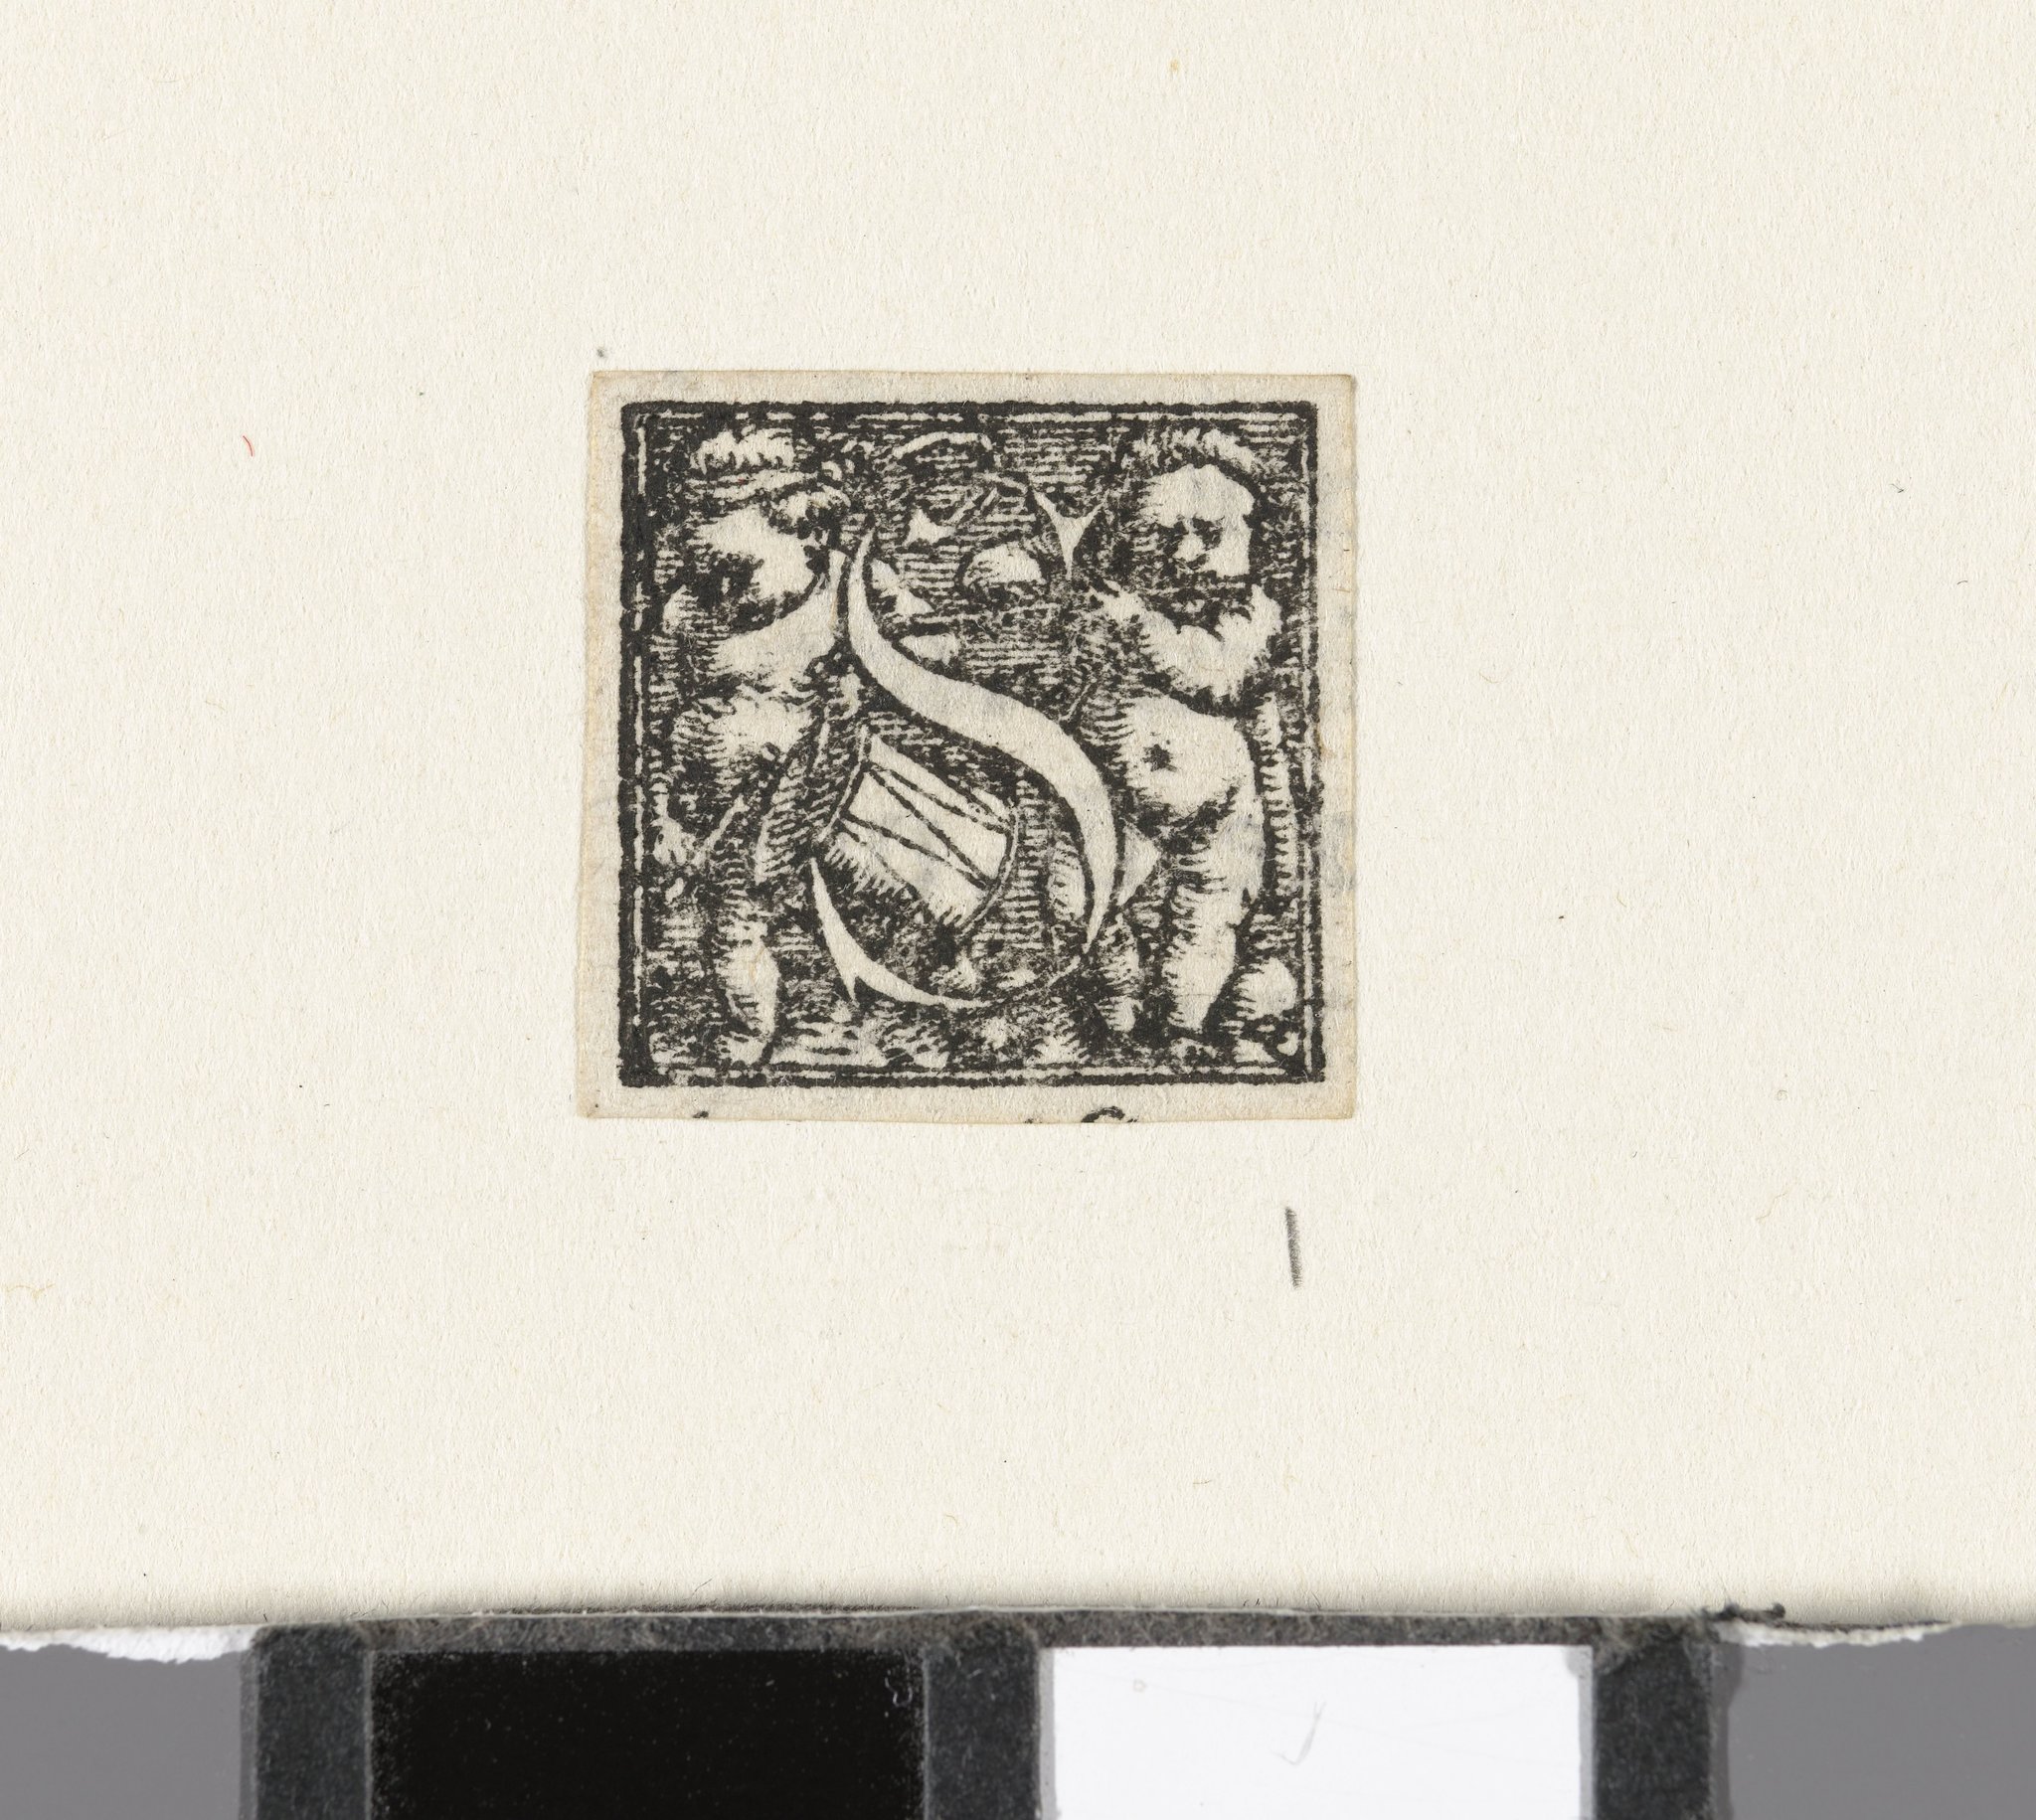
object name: print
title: Letter S met kind spelend op trommel en kind blazend op fluit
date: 1522-1524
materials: paper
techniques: woodcut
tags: letters, alphabet, script, child, children playing musical instruments